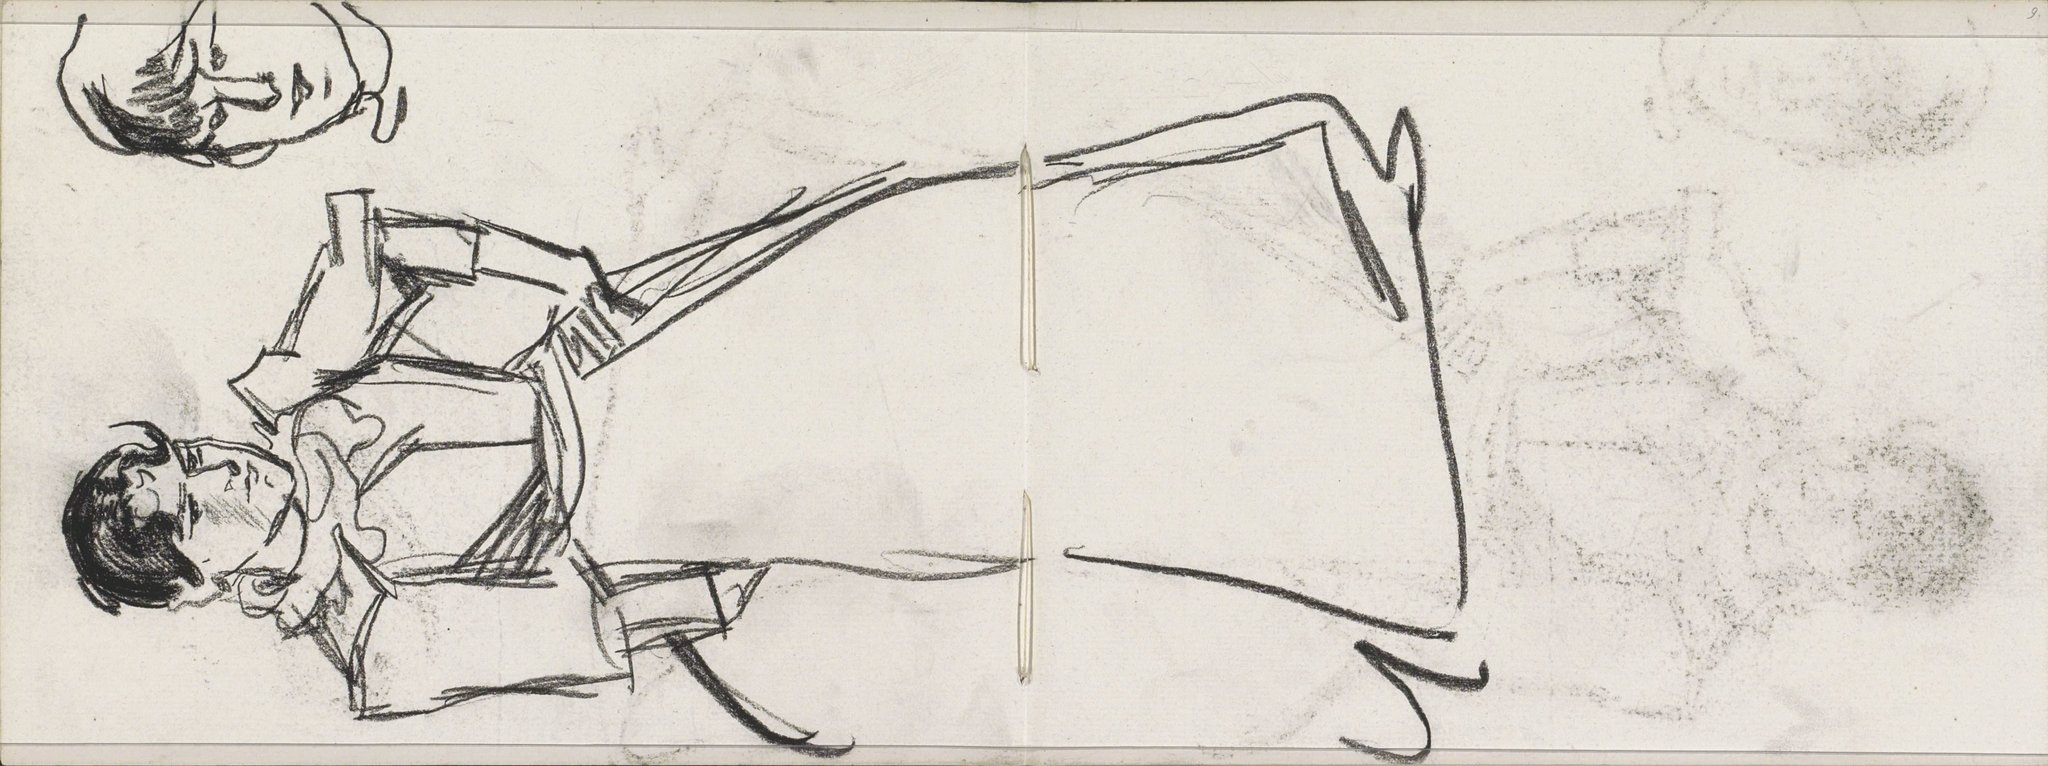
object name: sketchbook leaf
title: Vrouwenhoofd en een staande vrouw met schort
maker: isaac israels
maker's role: draughtsman, painter, print maker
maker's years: 1865-1934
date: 1875-1934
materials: chalk, paper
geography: the hague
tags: adult woman (+ standing), head (human) - aa - female human figure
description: Pagina 8 en pagina 9 uit schetsboek XLI met 38 pagina's.